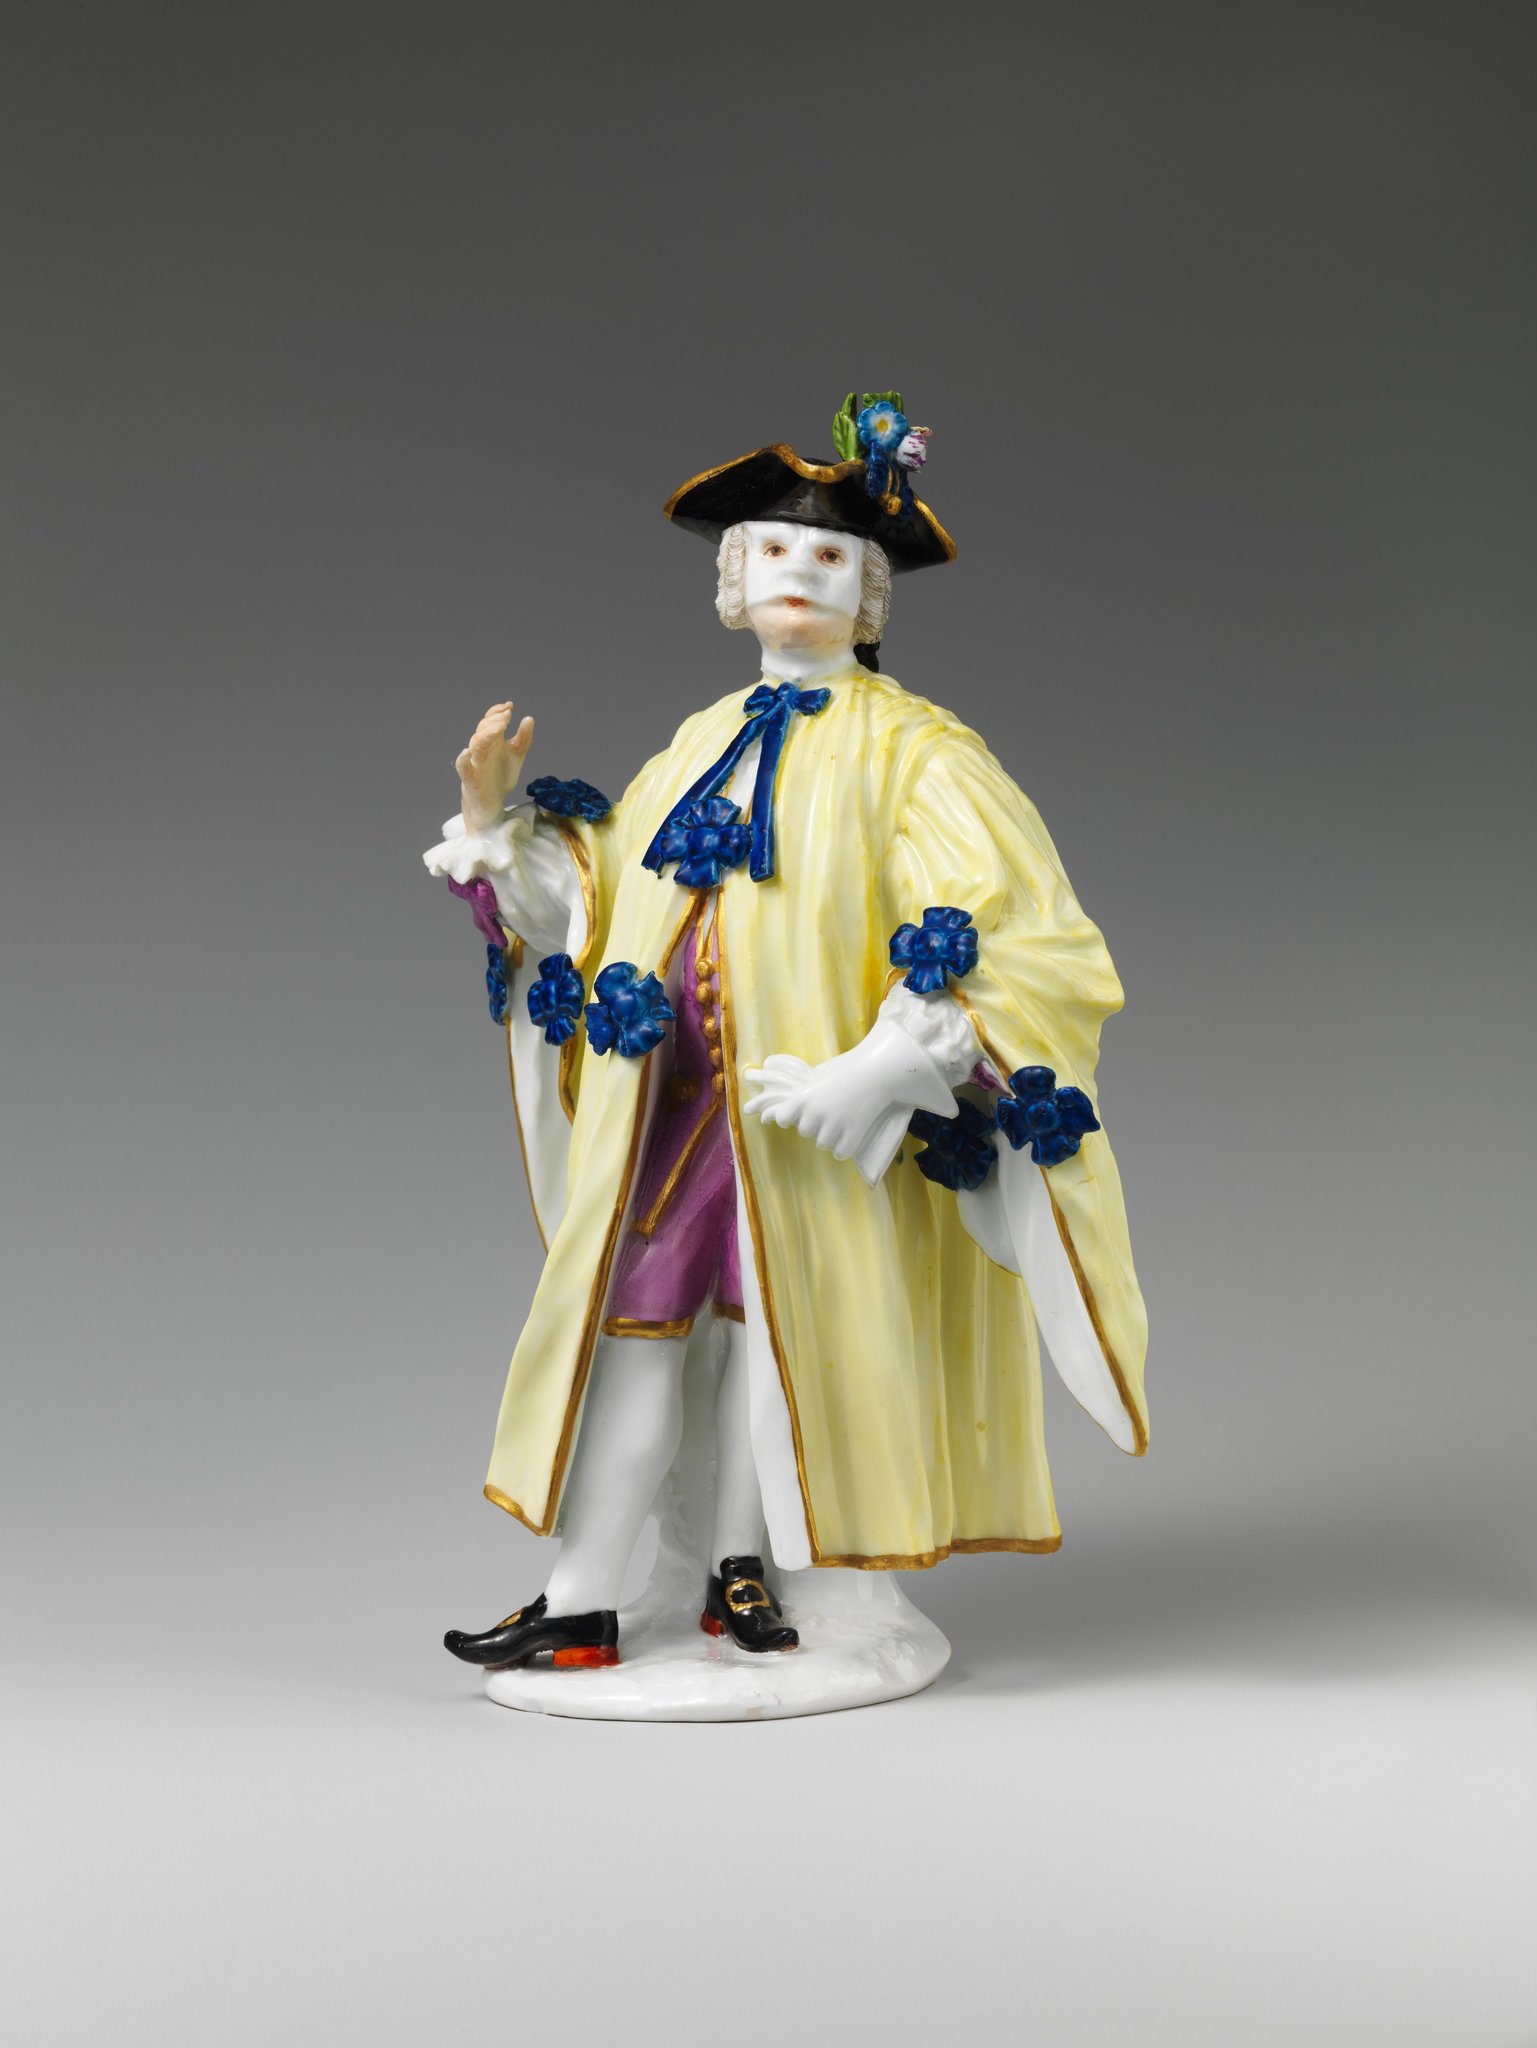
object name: figure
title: Masquerader (one of a pair)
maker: meissen manufactory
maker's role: manufactory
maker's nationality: german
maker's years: 1710-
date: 1745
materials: hard paste porcelain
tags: masks,men